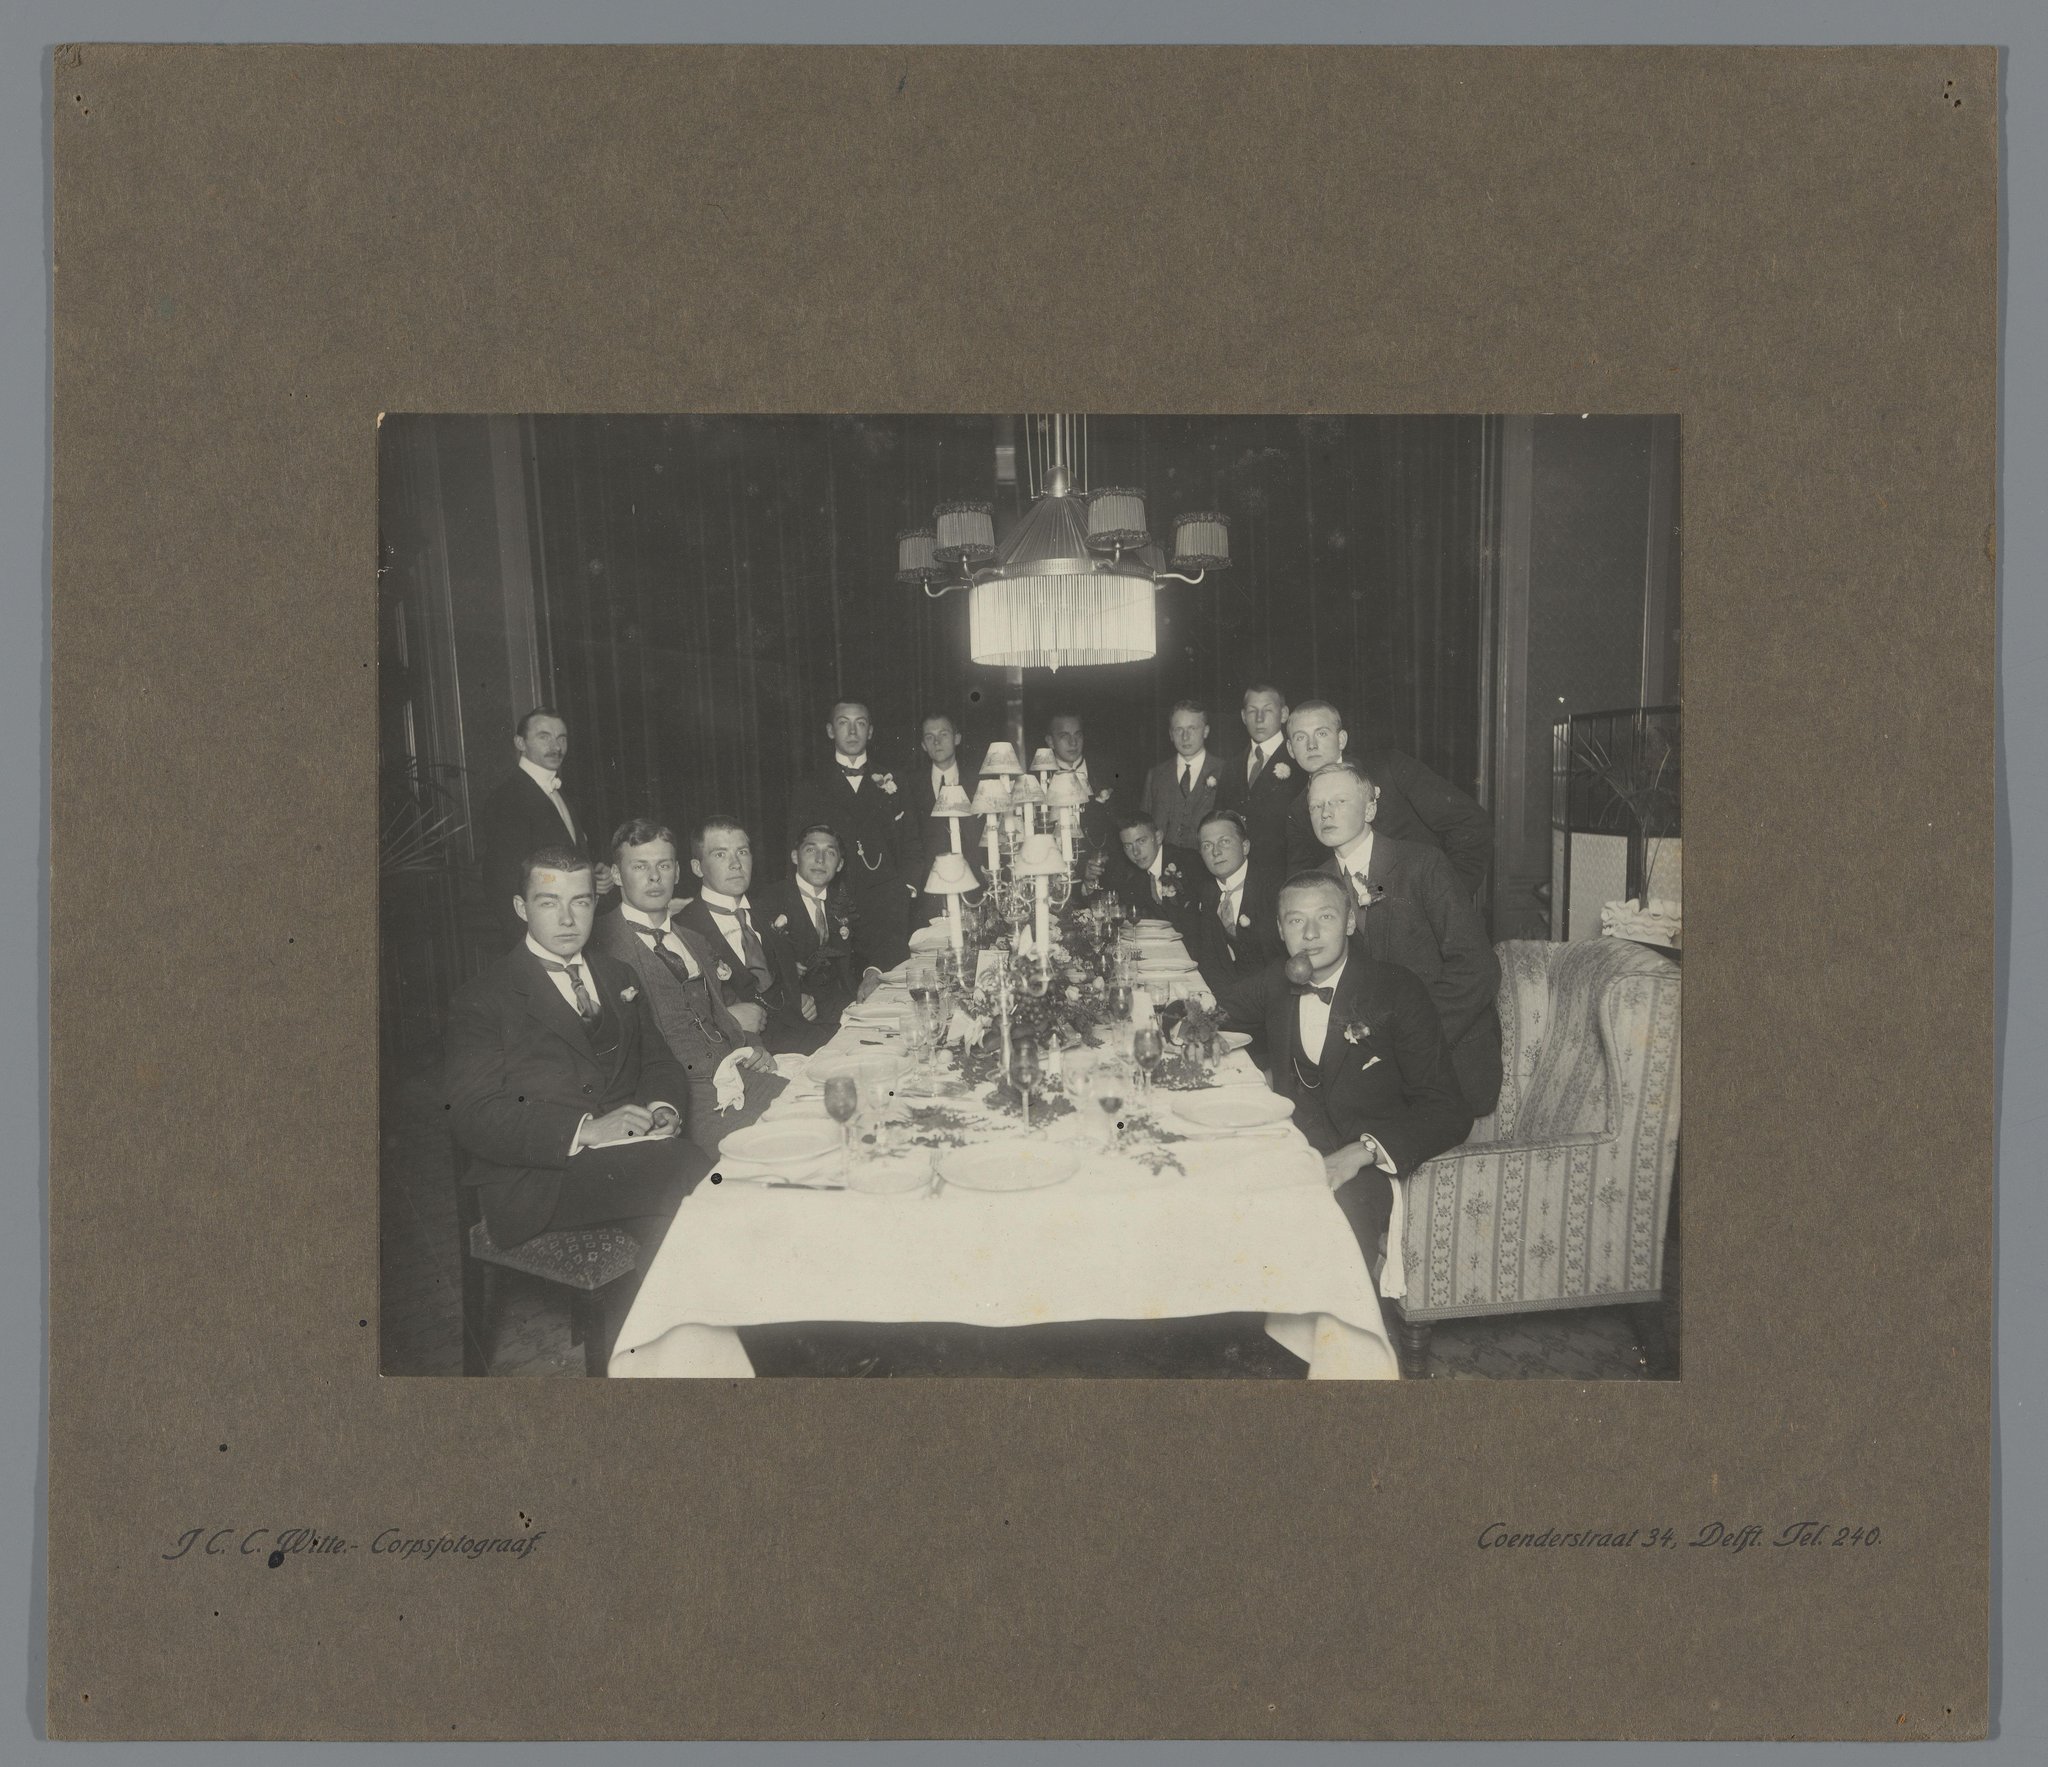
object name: photograph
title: Studentengezelschap aan tafel tijdens een feest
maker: j.c.c. witte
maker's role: fotograaf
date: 1914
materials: paper, cardboard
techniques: gelatin silver print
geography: delft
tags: rowing facing backward, pulling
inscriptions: inscription: ‘Loontje's fuif [?]/ 1914./ v.l.n.r./ Lefebvre/ Roodenburg/ Romeyn/ [...]’, address: ‘J.C.C. Witte. -Corpsfotograaf. Coenderstraat 34, Delft. Tel. 240.’